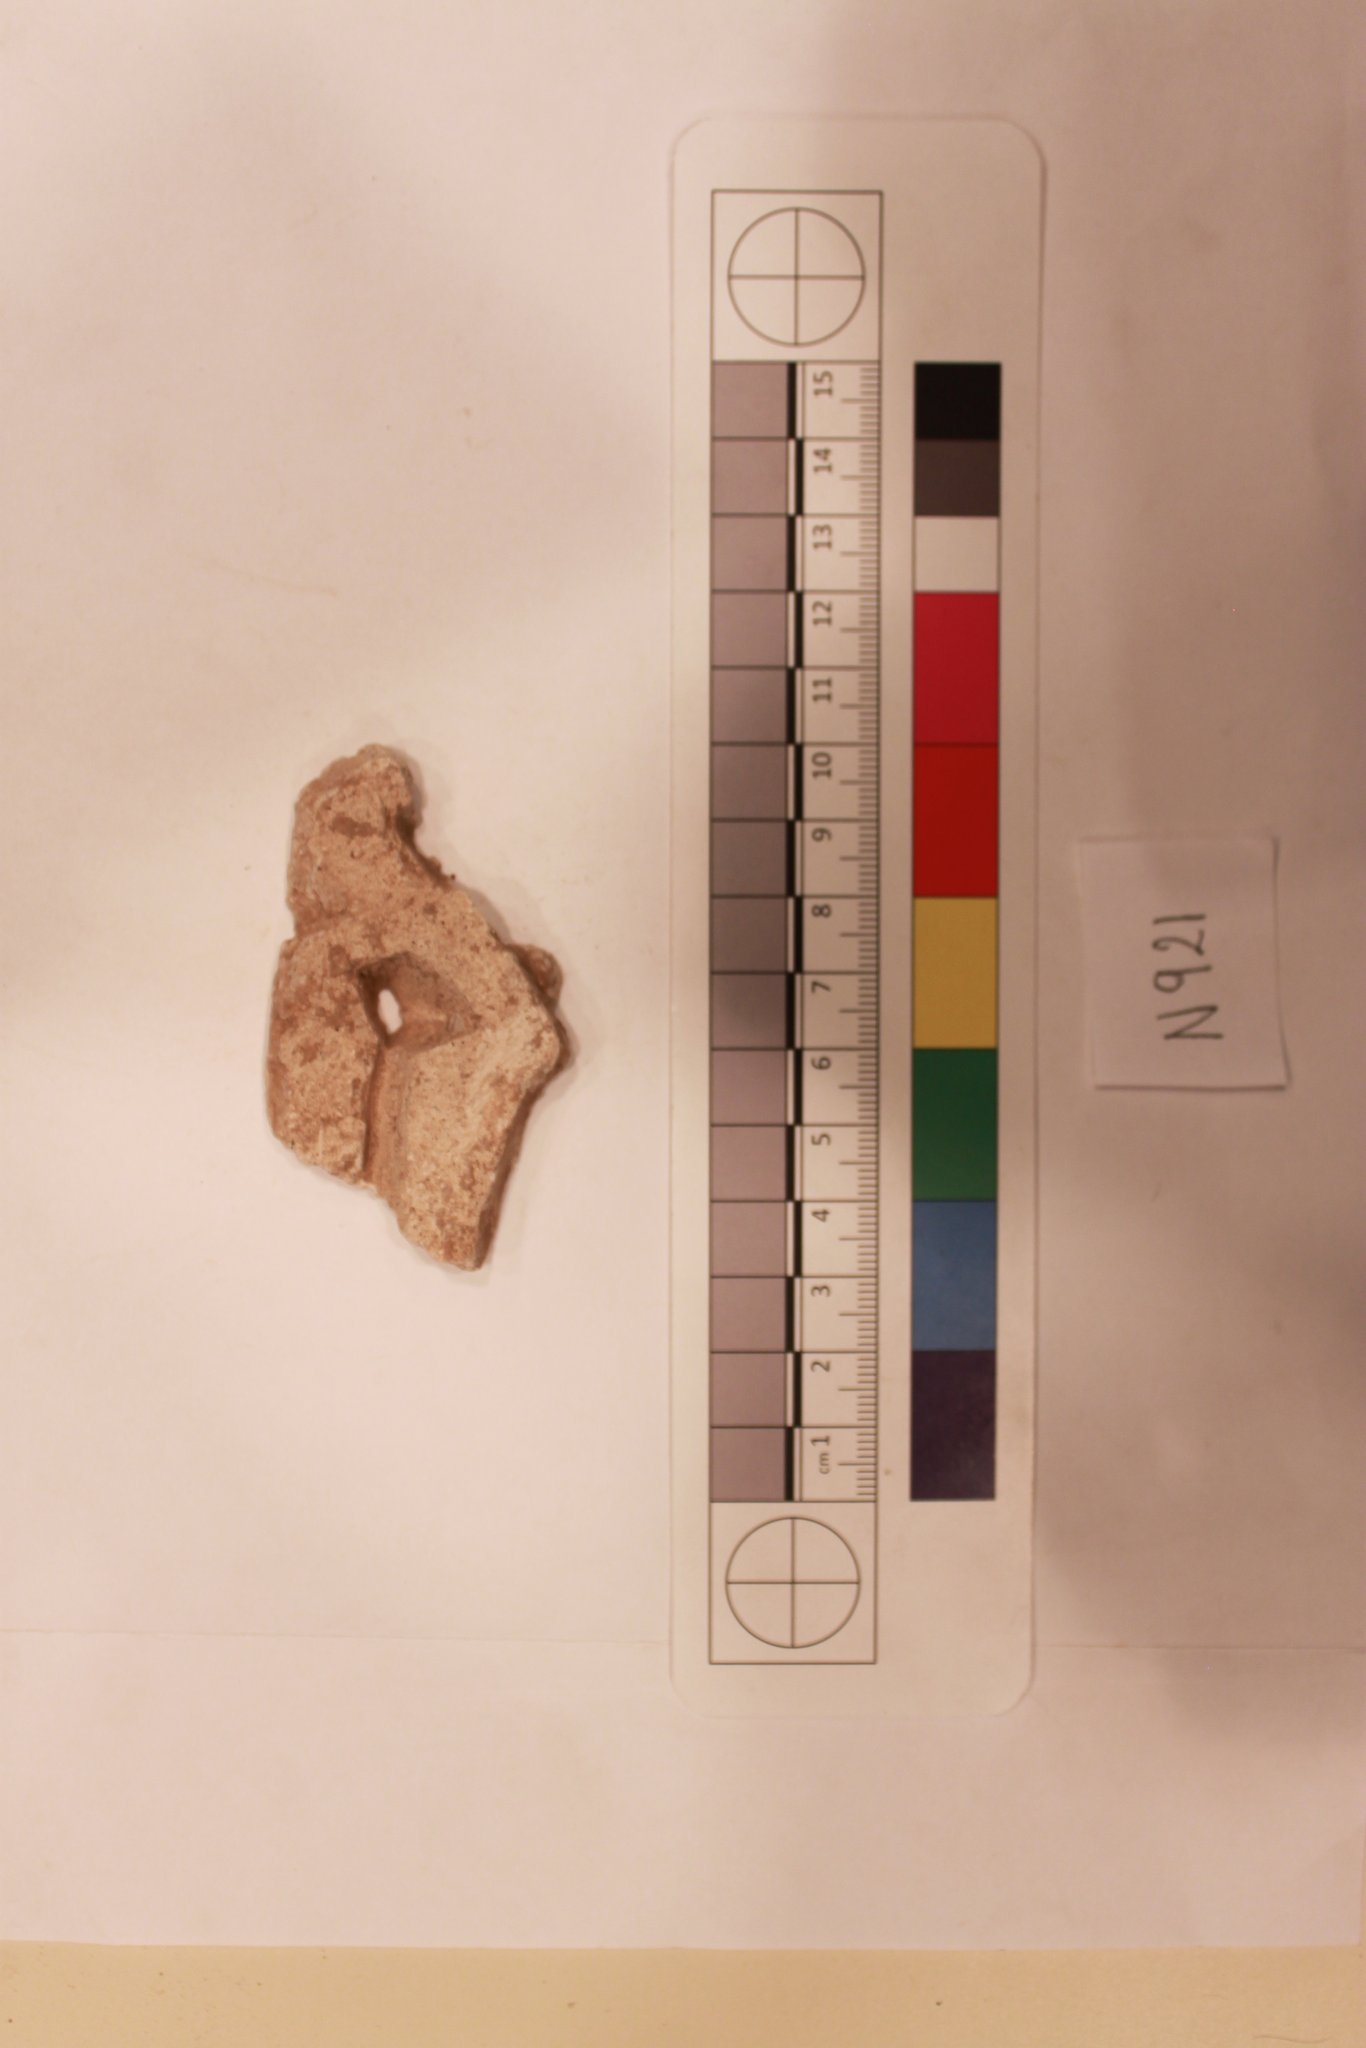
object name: fragment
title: Stucco Fragment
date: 701-1200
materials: plaster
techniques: carving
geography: iran